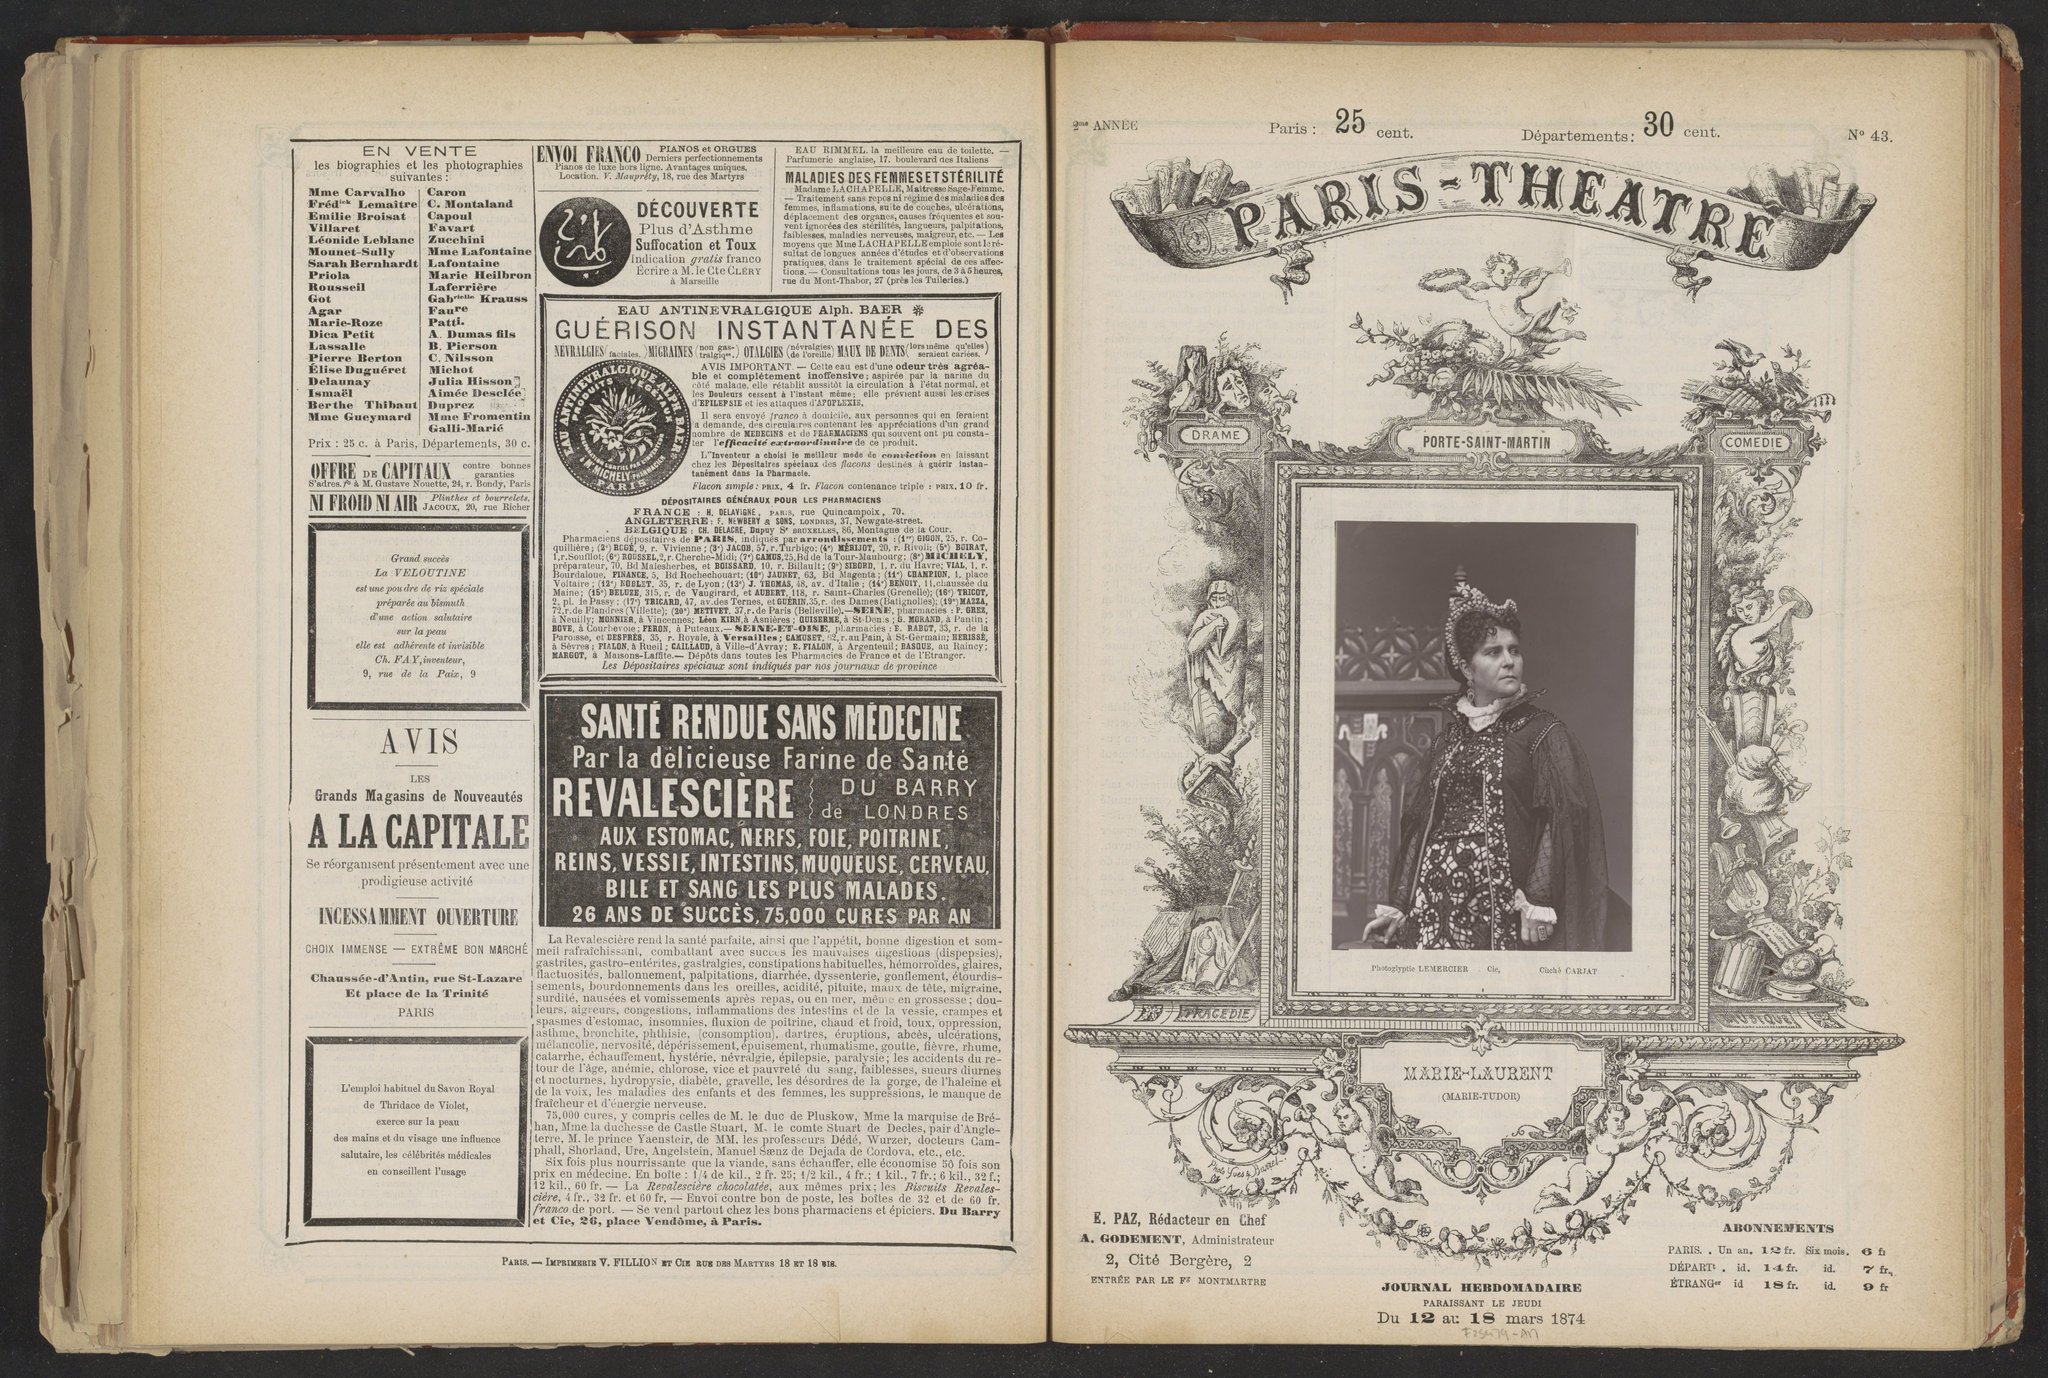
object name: page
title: Portret van Marie Laurent in Marie Tudor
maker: étienne carjat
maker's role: draughtsman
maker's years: 1828-1906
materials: paper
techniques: woodburytype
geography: france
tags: portrait of actor, actress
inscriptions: inscription: ‘Journal hebdomadaire paraissant le Jeudi Du 12 au 18 mars 1874’, number: ‘No 43.’